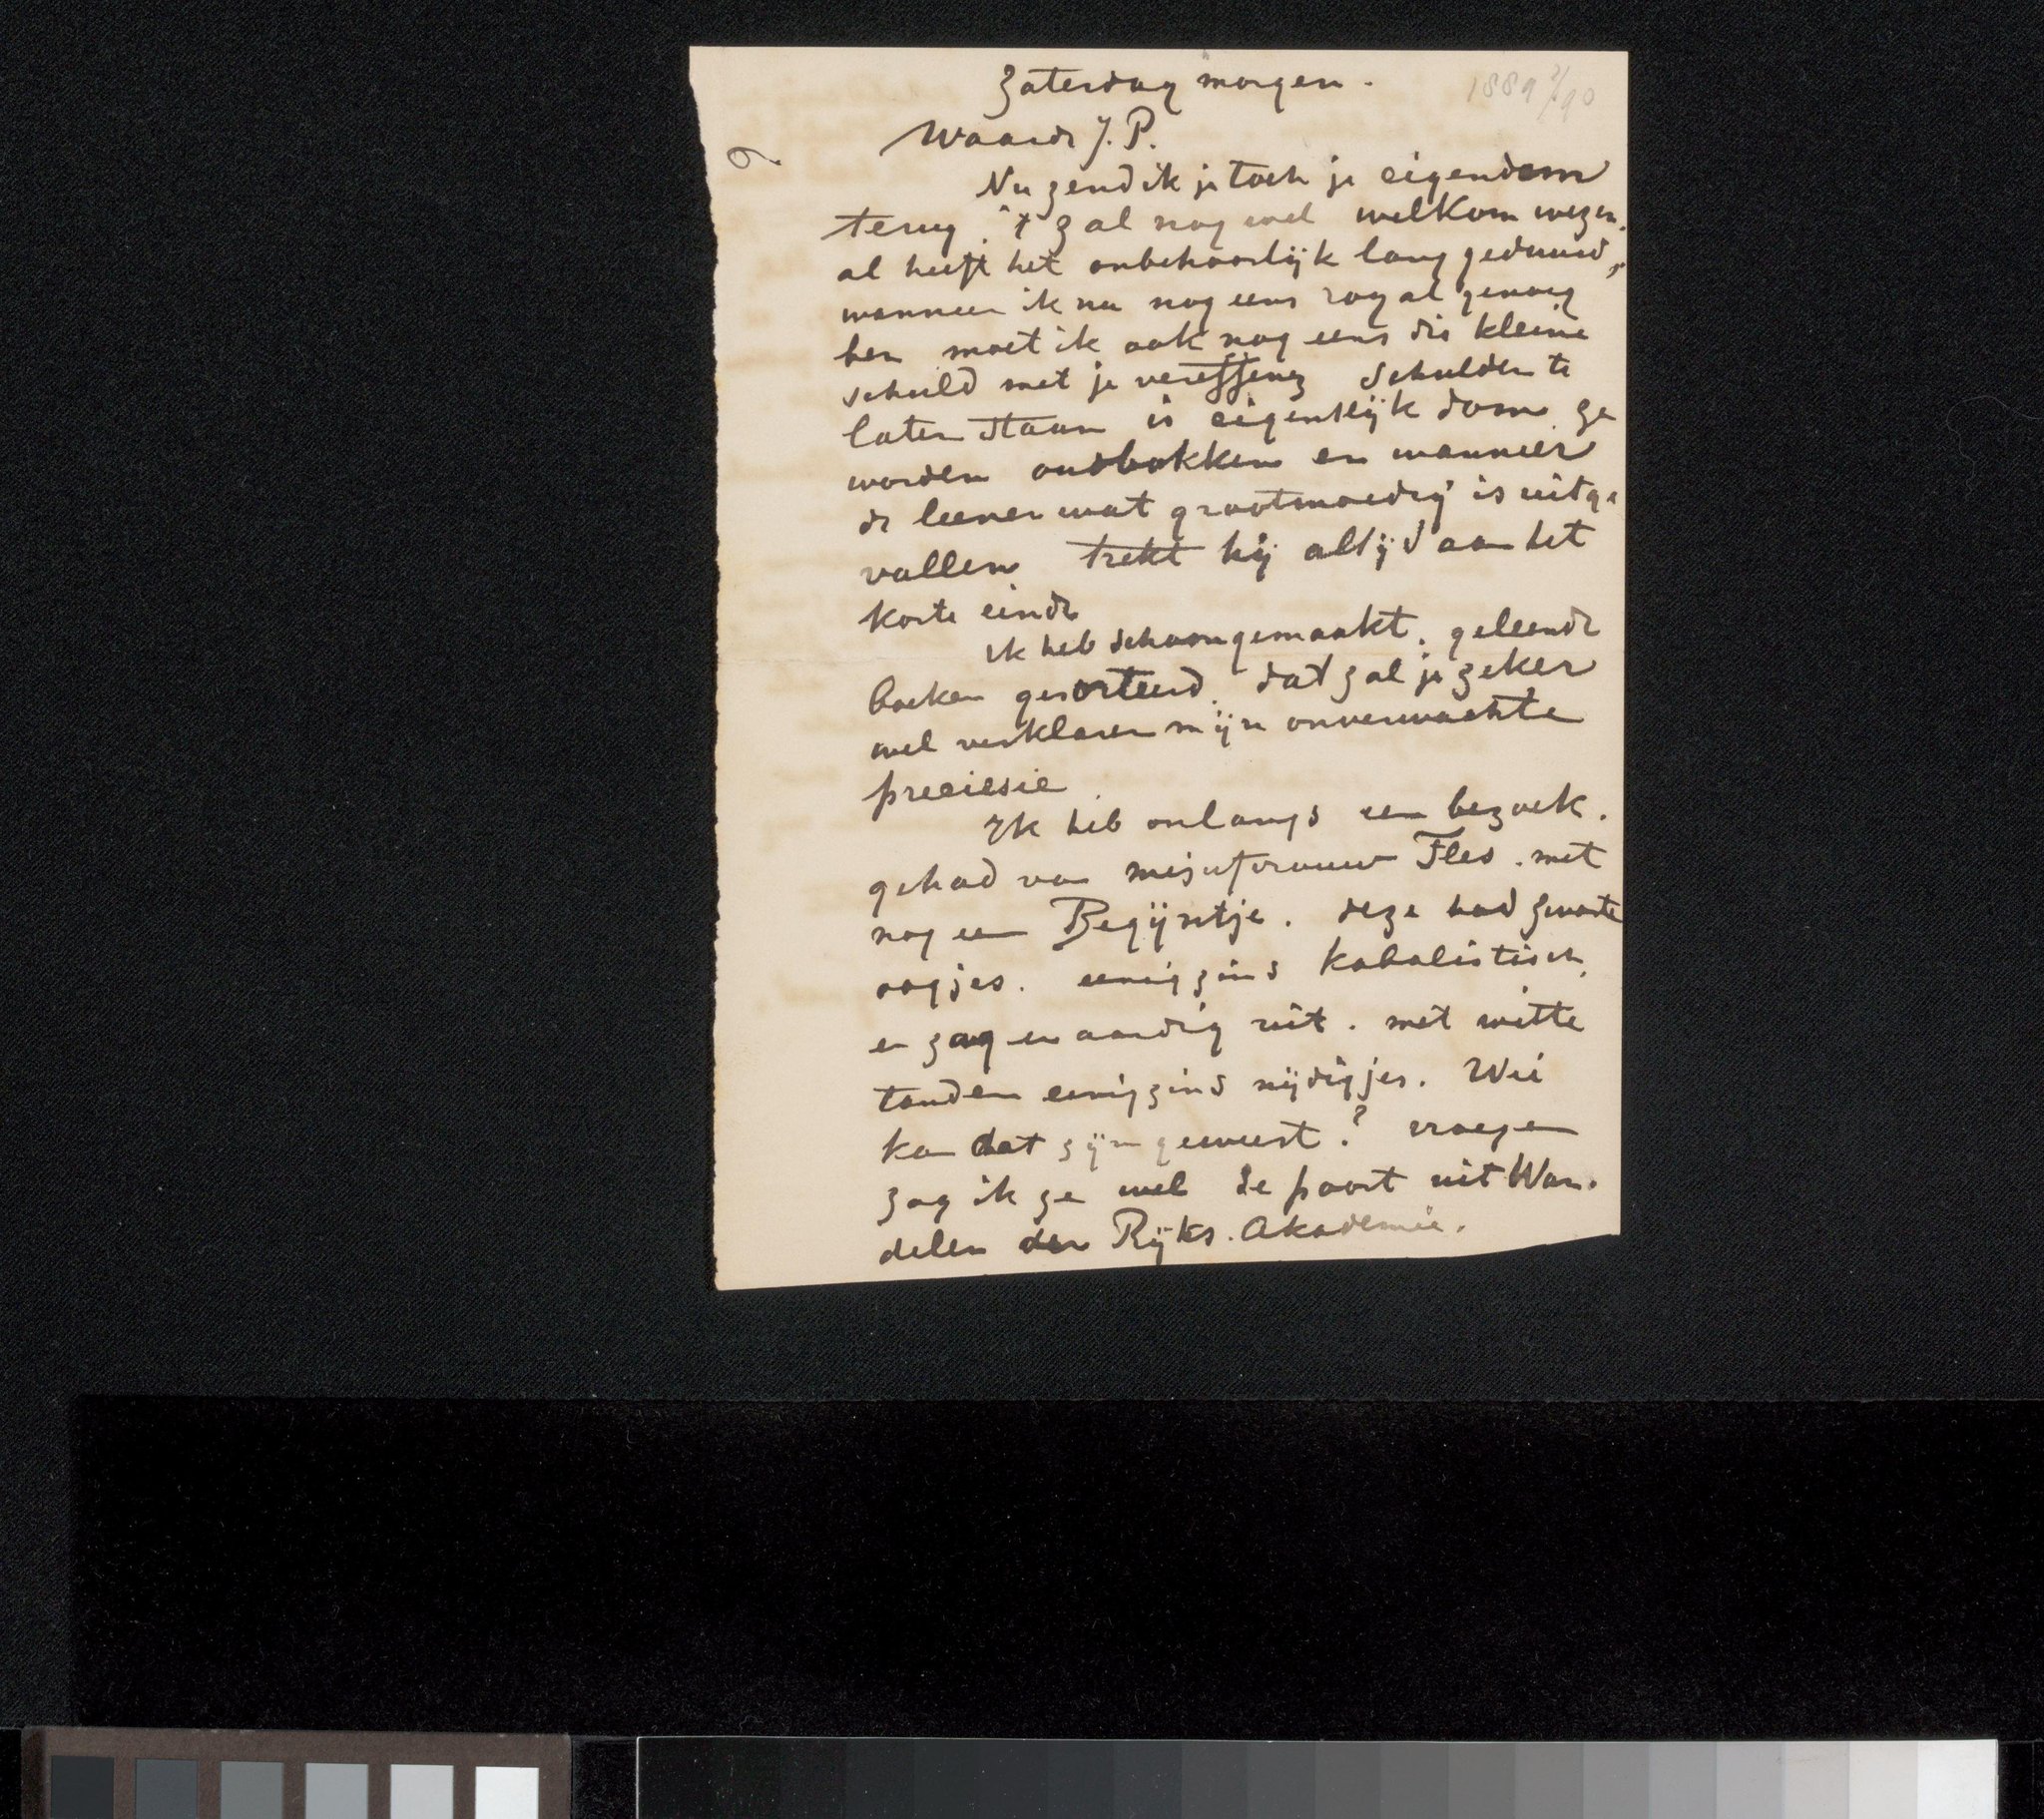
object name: letter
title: Brief aan Jan Veth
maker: jac van looij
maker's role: draughtsman, painter, print maker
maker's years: 1855-1930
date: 1865-1925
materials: ink, paper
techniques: pen, writing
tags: dordrecht, amsterdam, painter, print maker, draughtsman, designer, jan veth, etha fles, painting (including book-illumination, miniature-painting)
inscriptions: collector's mark: ‘RPK’